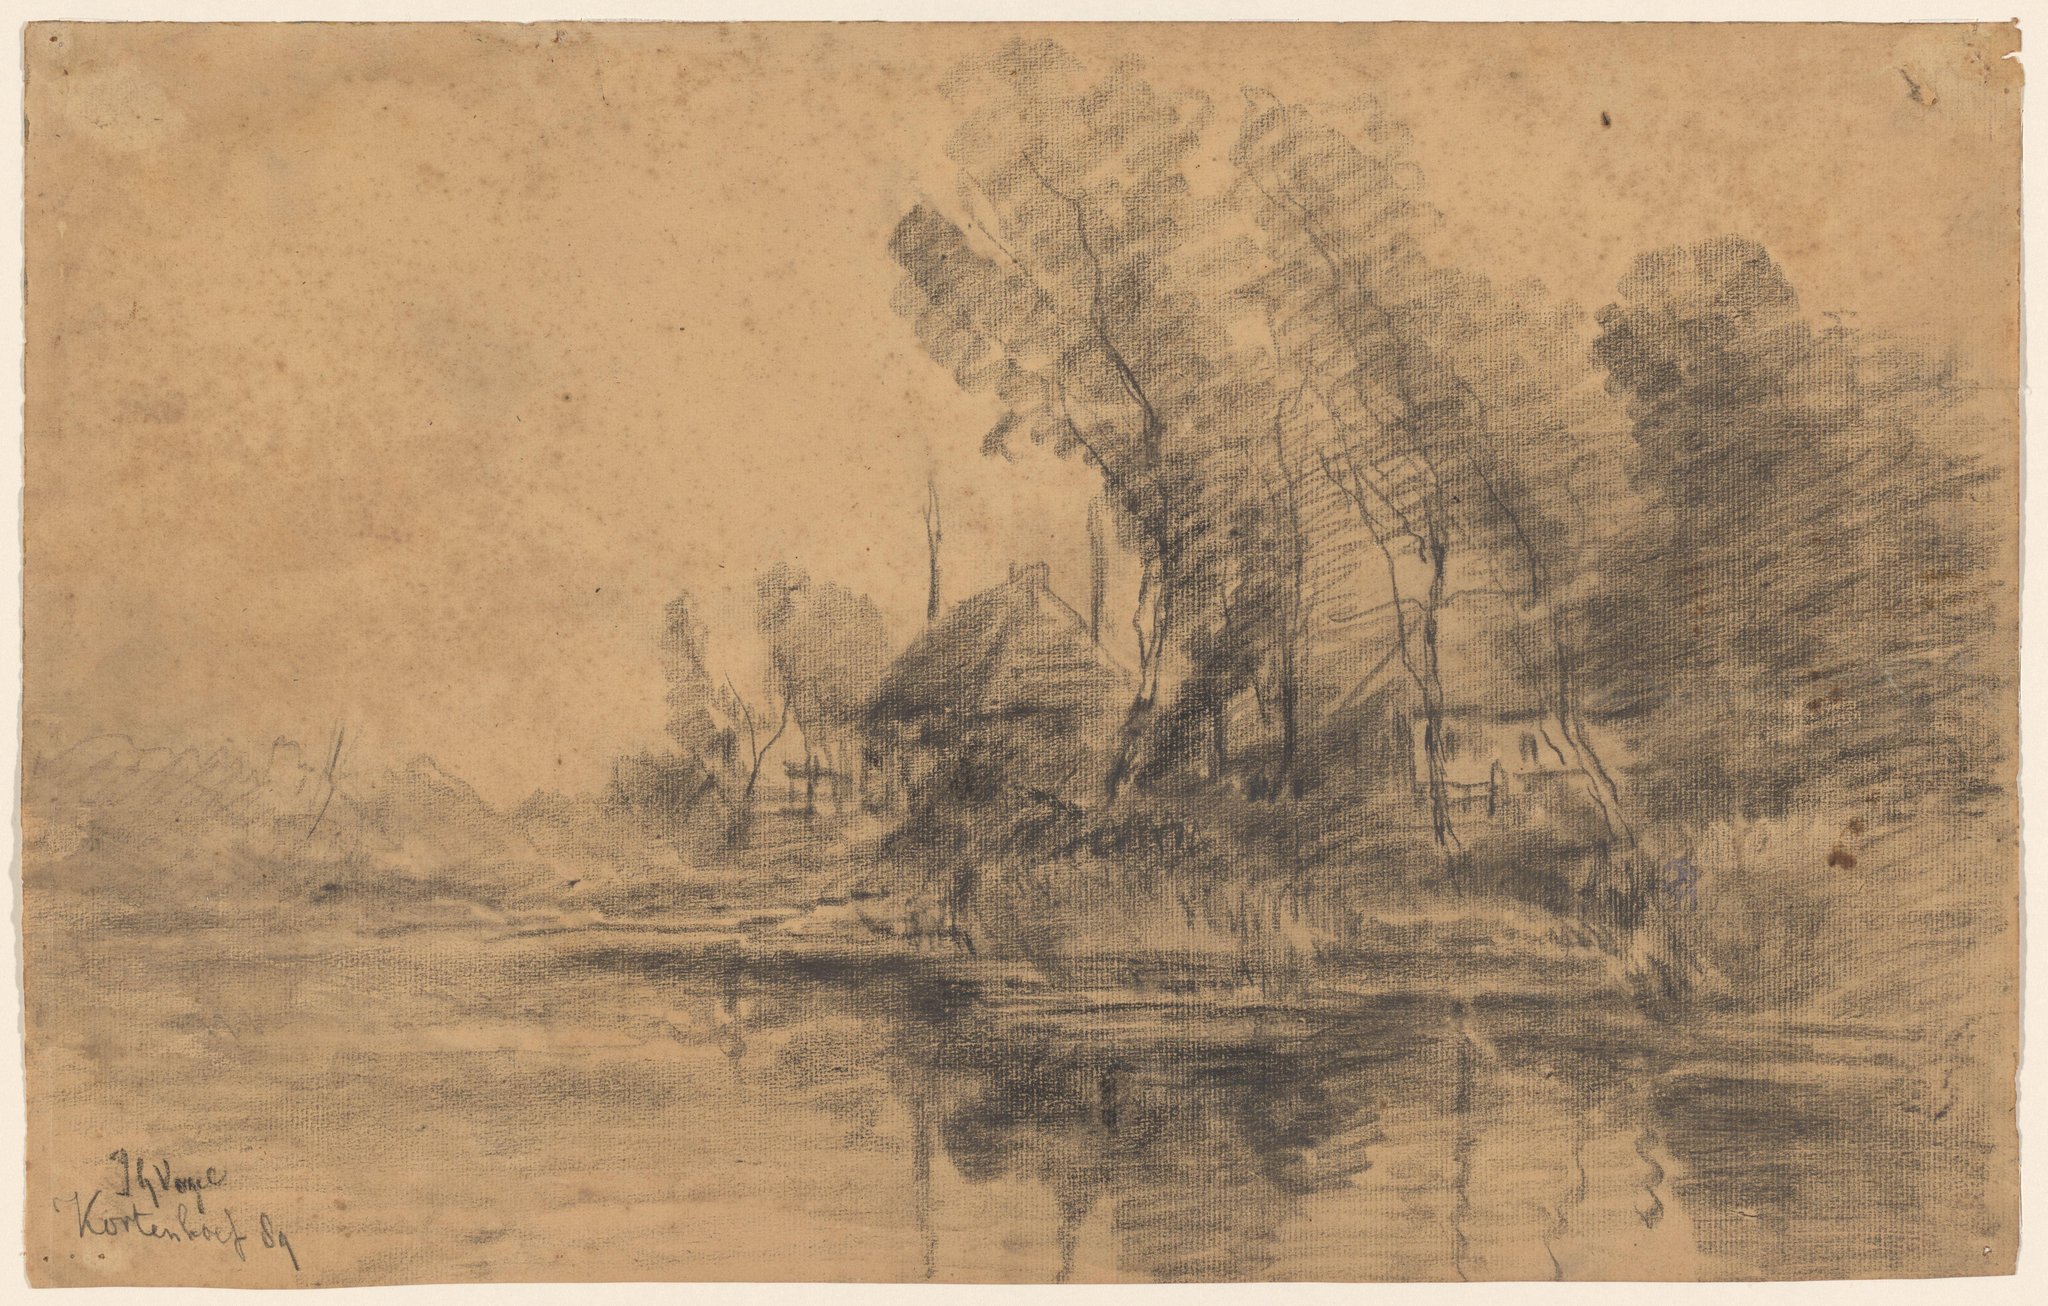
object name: drawing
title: Huizen aan het water bij Kortenhoef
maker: johannes gijsbert vogel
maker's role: draughtsman, painter, print maker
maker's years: 1828-1915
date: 1889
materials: chalk, paper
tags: prospect of village, silhouette of village, landscapes with waters, waterscapes, seascapes (in the temperate zone)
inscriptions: date and inscription: ‘Kortenhoef 89’, collector's mark: Lugt 1181b